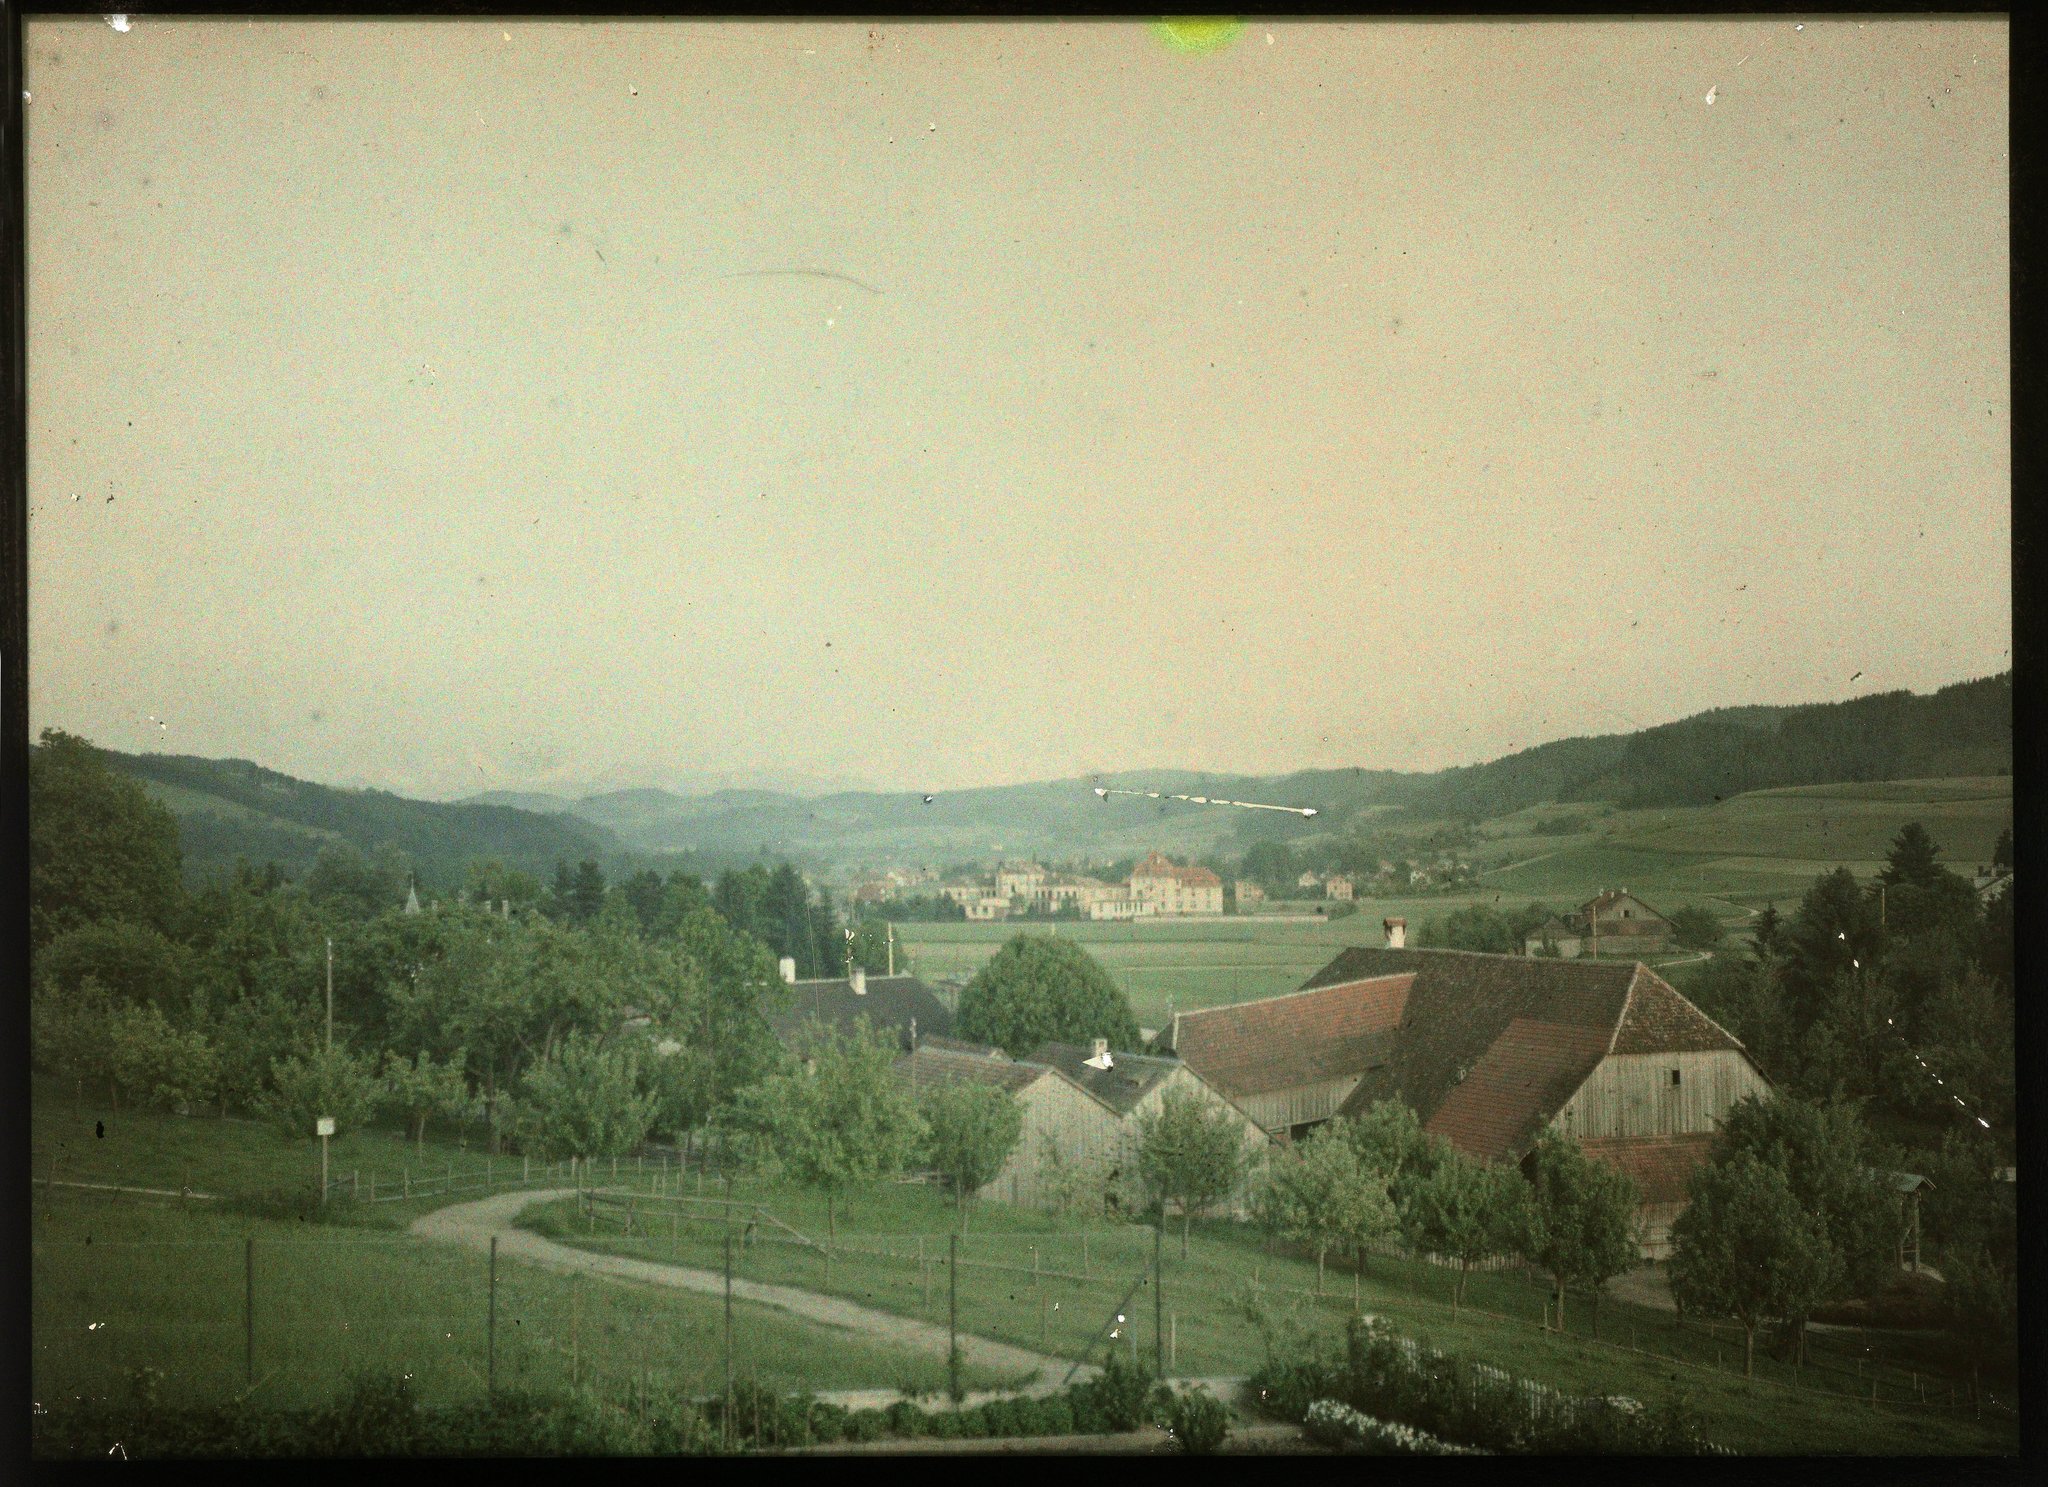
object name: photograph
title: Gezicht op boerderijen, met op de achtergrond een stadje met witte huizen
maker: adolphe burdet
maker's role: fotograaf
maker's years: 1860-1940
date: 1907-1930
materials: glass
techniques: autochrome process, slide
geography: switzerland